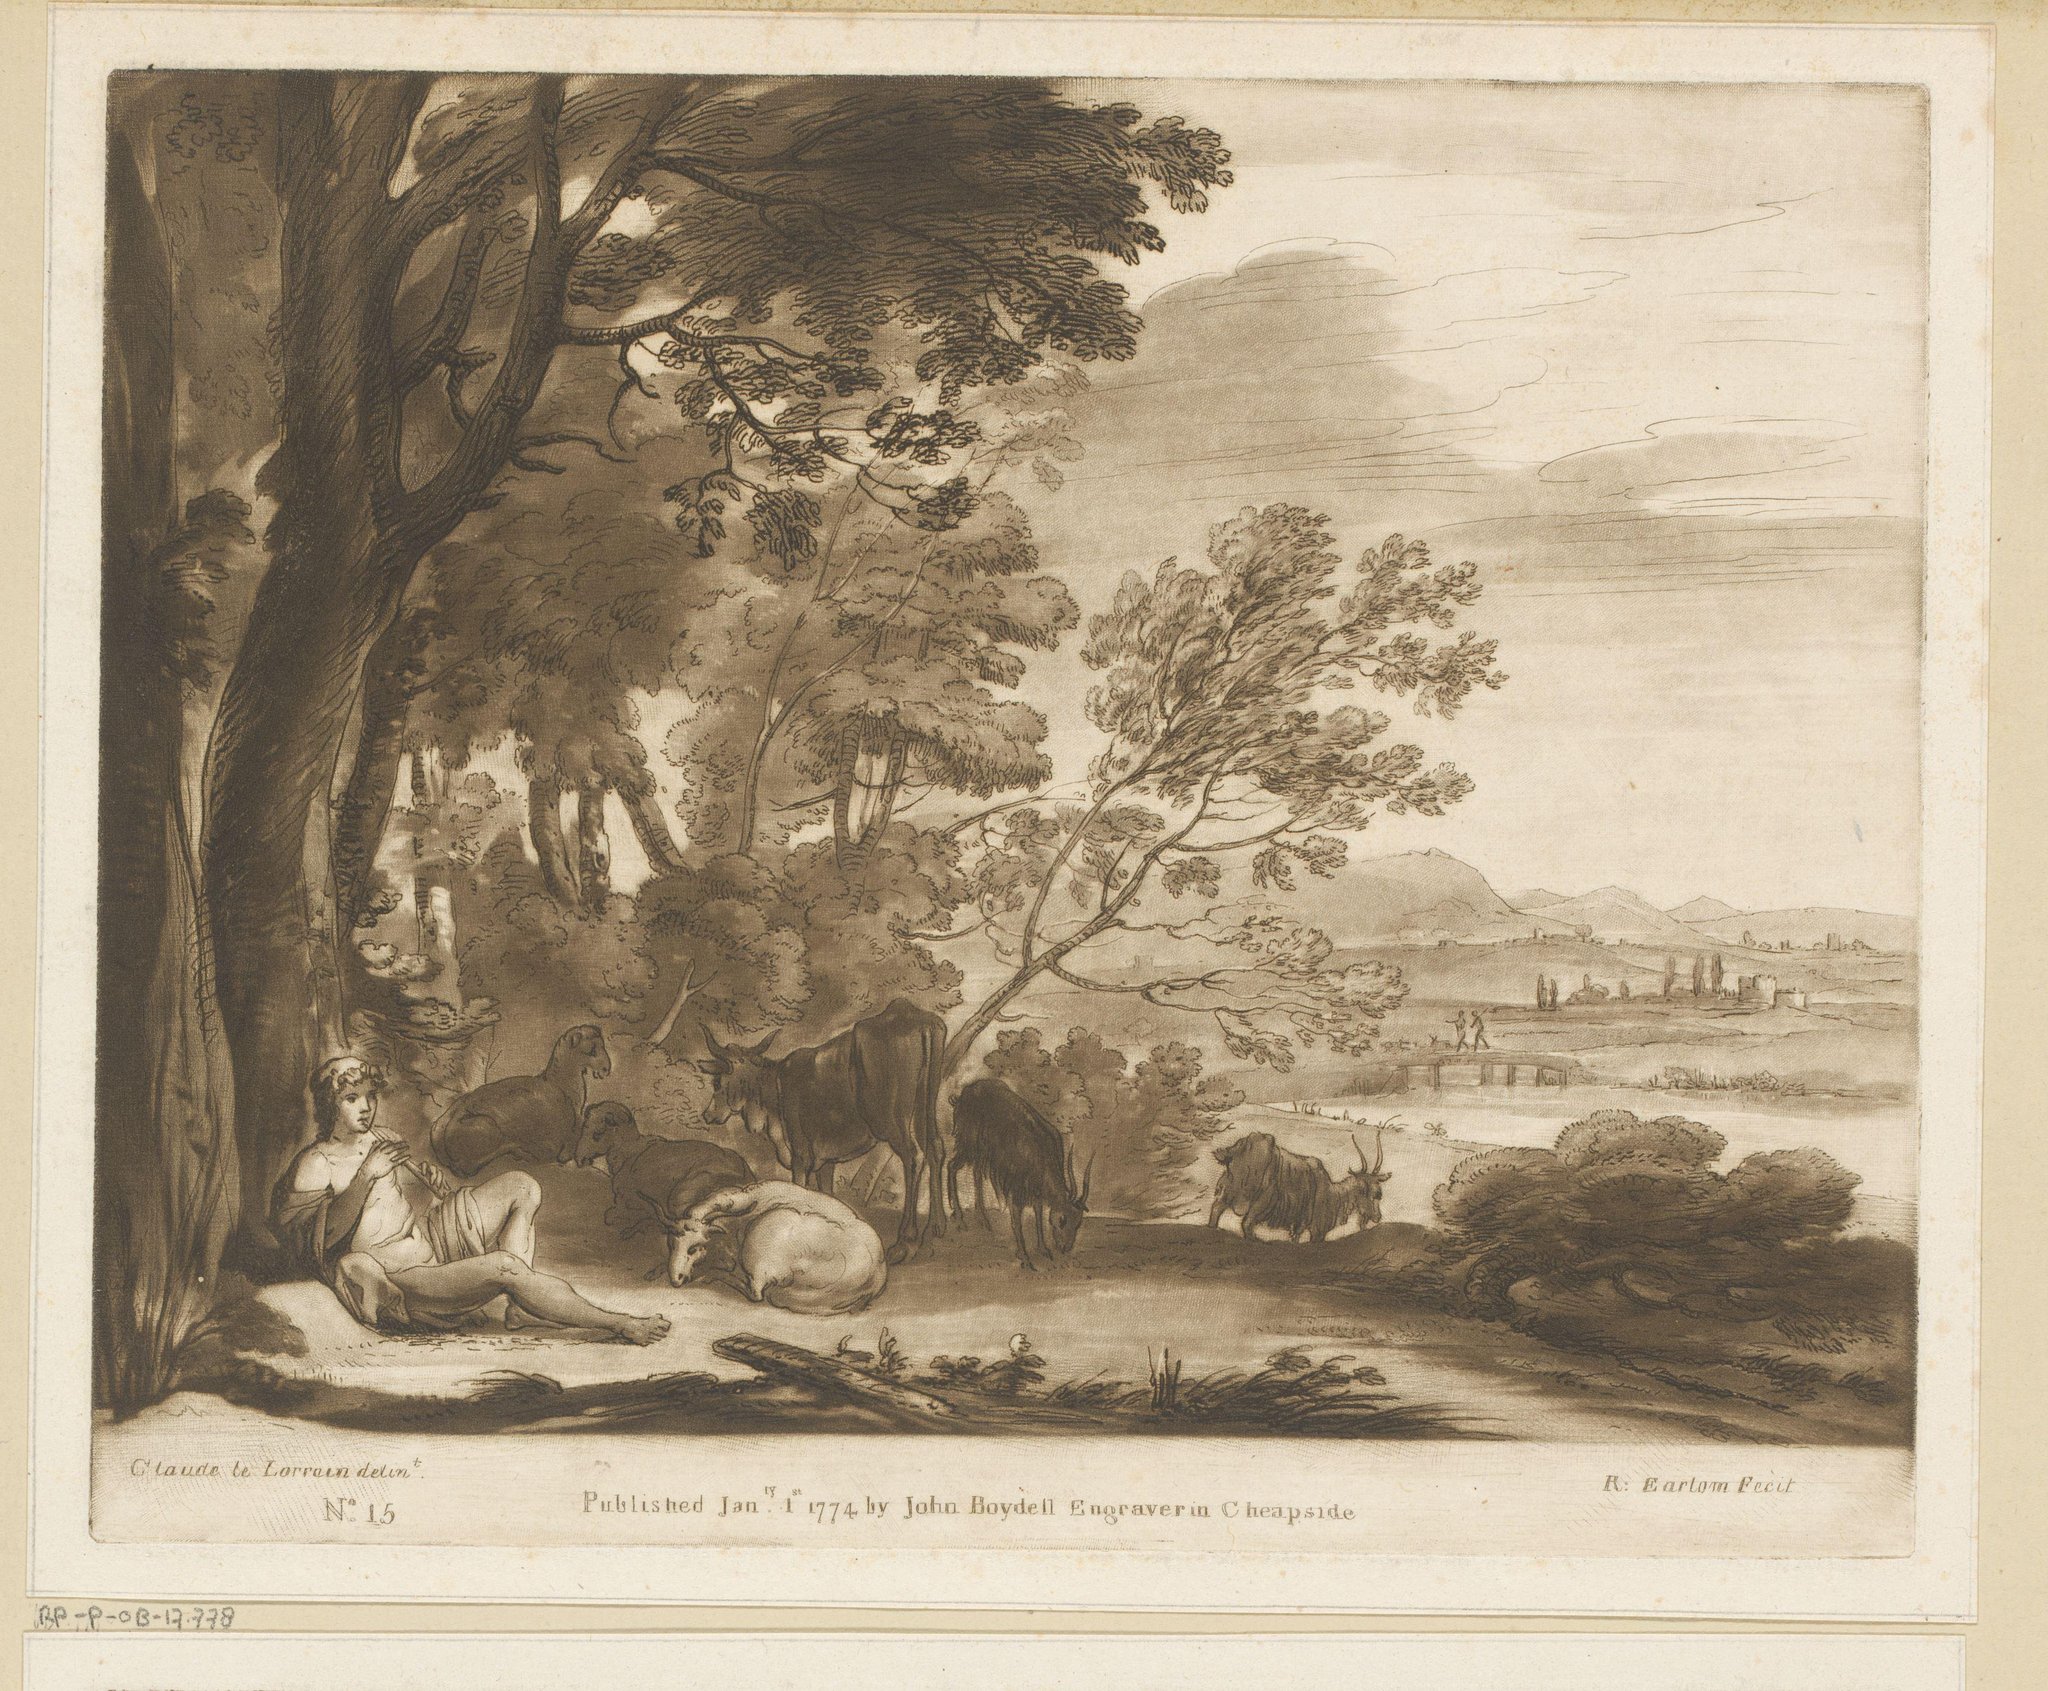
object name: print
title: Prenten naar tekeningen van Claude Lorrain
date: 1774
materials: paper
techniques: etching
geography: london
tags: herding, herdsman, herdswoman, shepherd, shepherdess, cowherd, etc., cattle, flute, aulos, tibia - cc - out of doors, pastorals, arcadian scenes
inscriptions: date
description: Vanaf 1774 publiceerde John Boydell tweehonderd prenten naar het tekeningenboek Liber Veritatis van Claude Lorrain, in het bezit van de hertogen van Cavendish. Deze werden vanaf 1777 in twee volumes gebundeld uitgegeven.